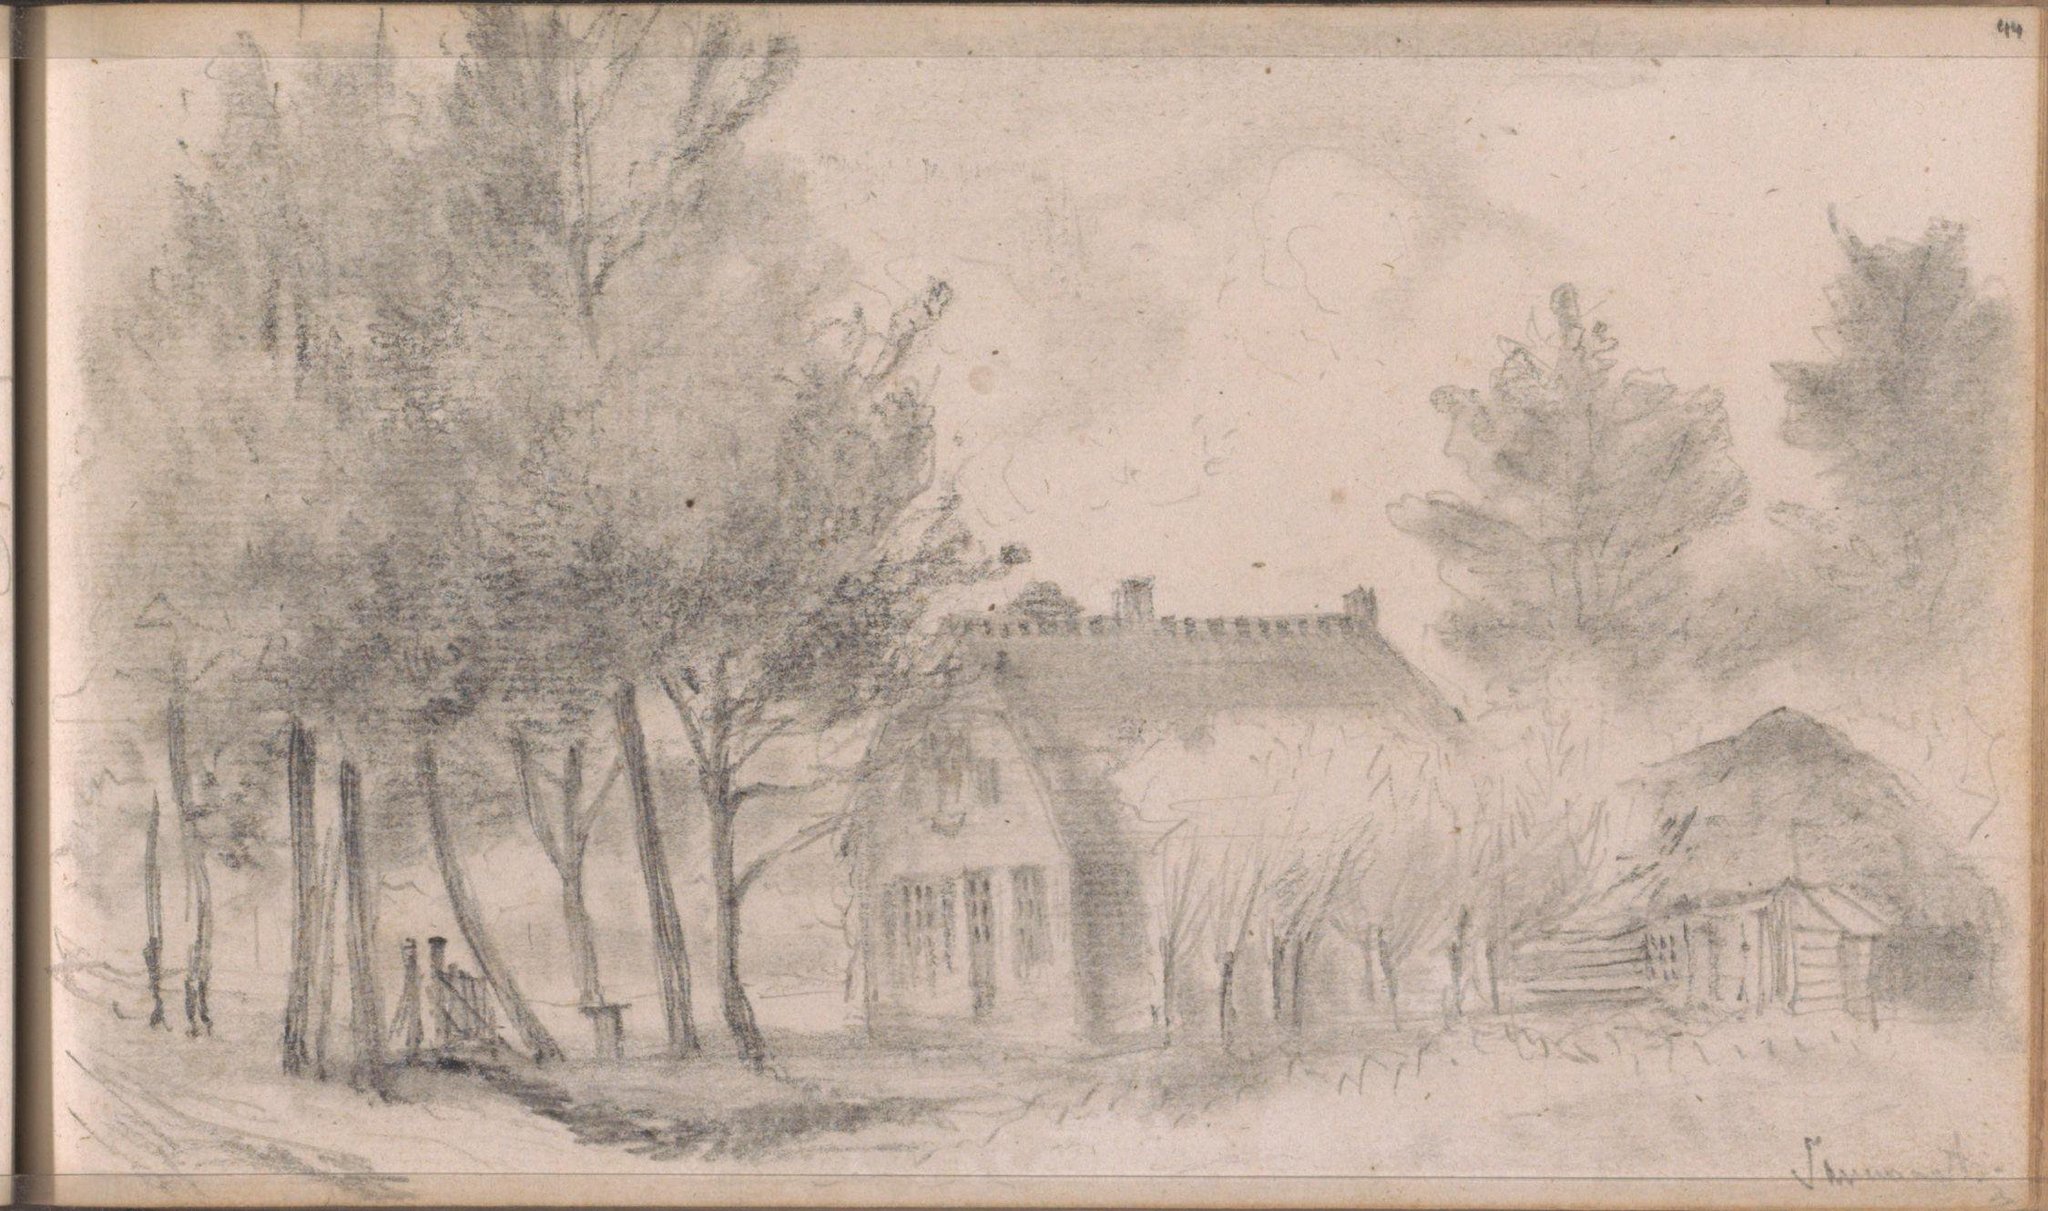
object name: sketchbook leaf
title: Sneppenschrik gezien vanuit de richting van Nieuwerkerk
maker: johannes tavenraat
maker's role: draughtsman, painter, print maker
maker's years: 1809-1881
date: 1808-1864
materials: paper, pencil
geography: capelle aan den ijssel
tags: rural housing, e.g. country-house, villa, cottage, road, path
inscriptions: signature: ‘Tavenraat’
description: Blad 44 recto uit een schetsboek met 98 bladen.